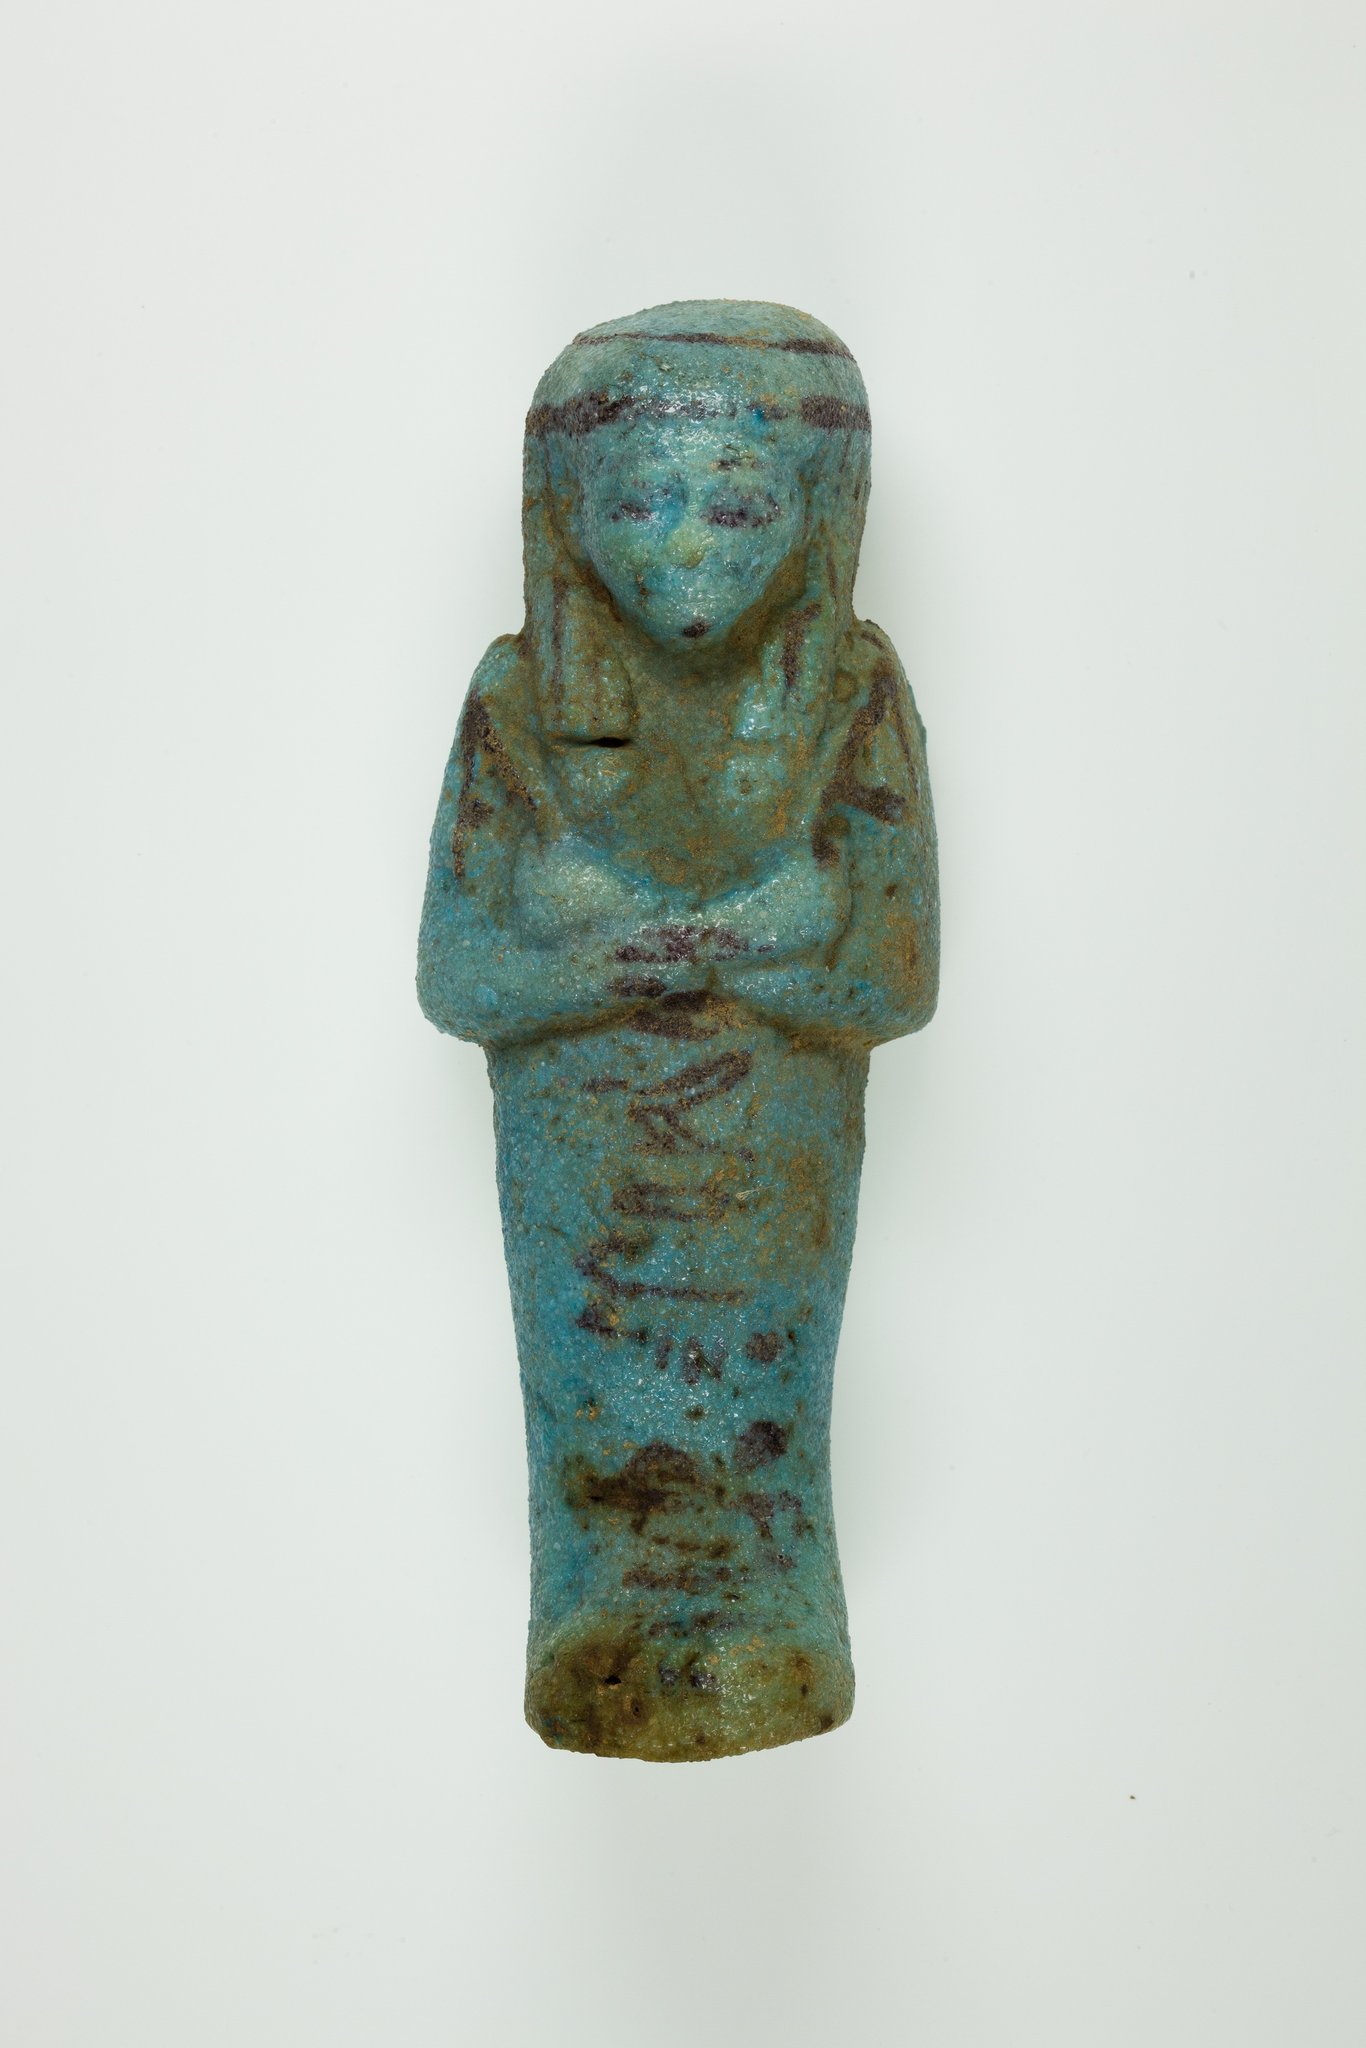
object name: worker shabti, henettawy c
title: Worker Shabti of Henettawy (C), Daughter of Isetemkheb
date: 990-970 BCE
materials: faience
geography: egypt